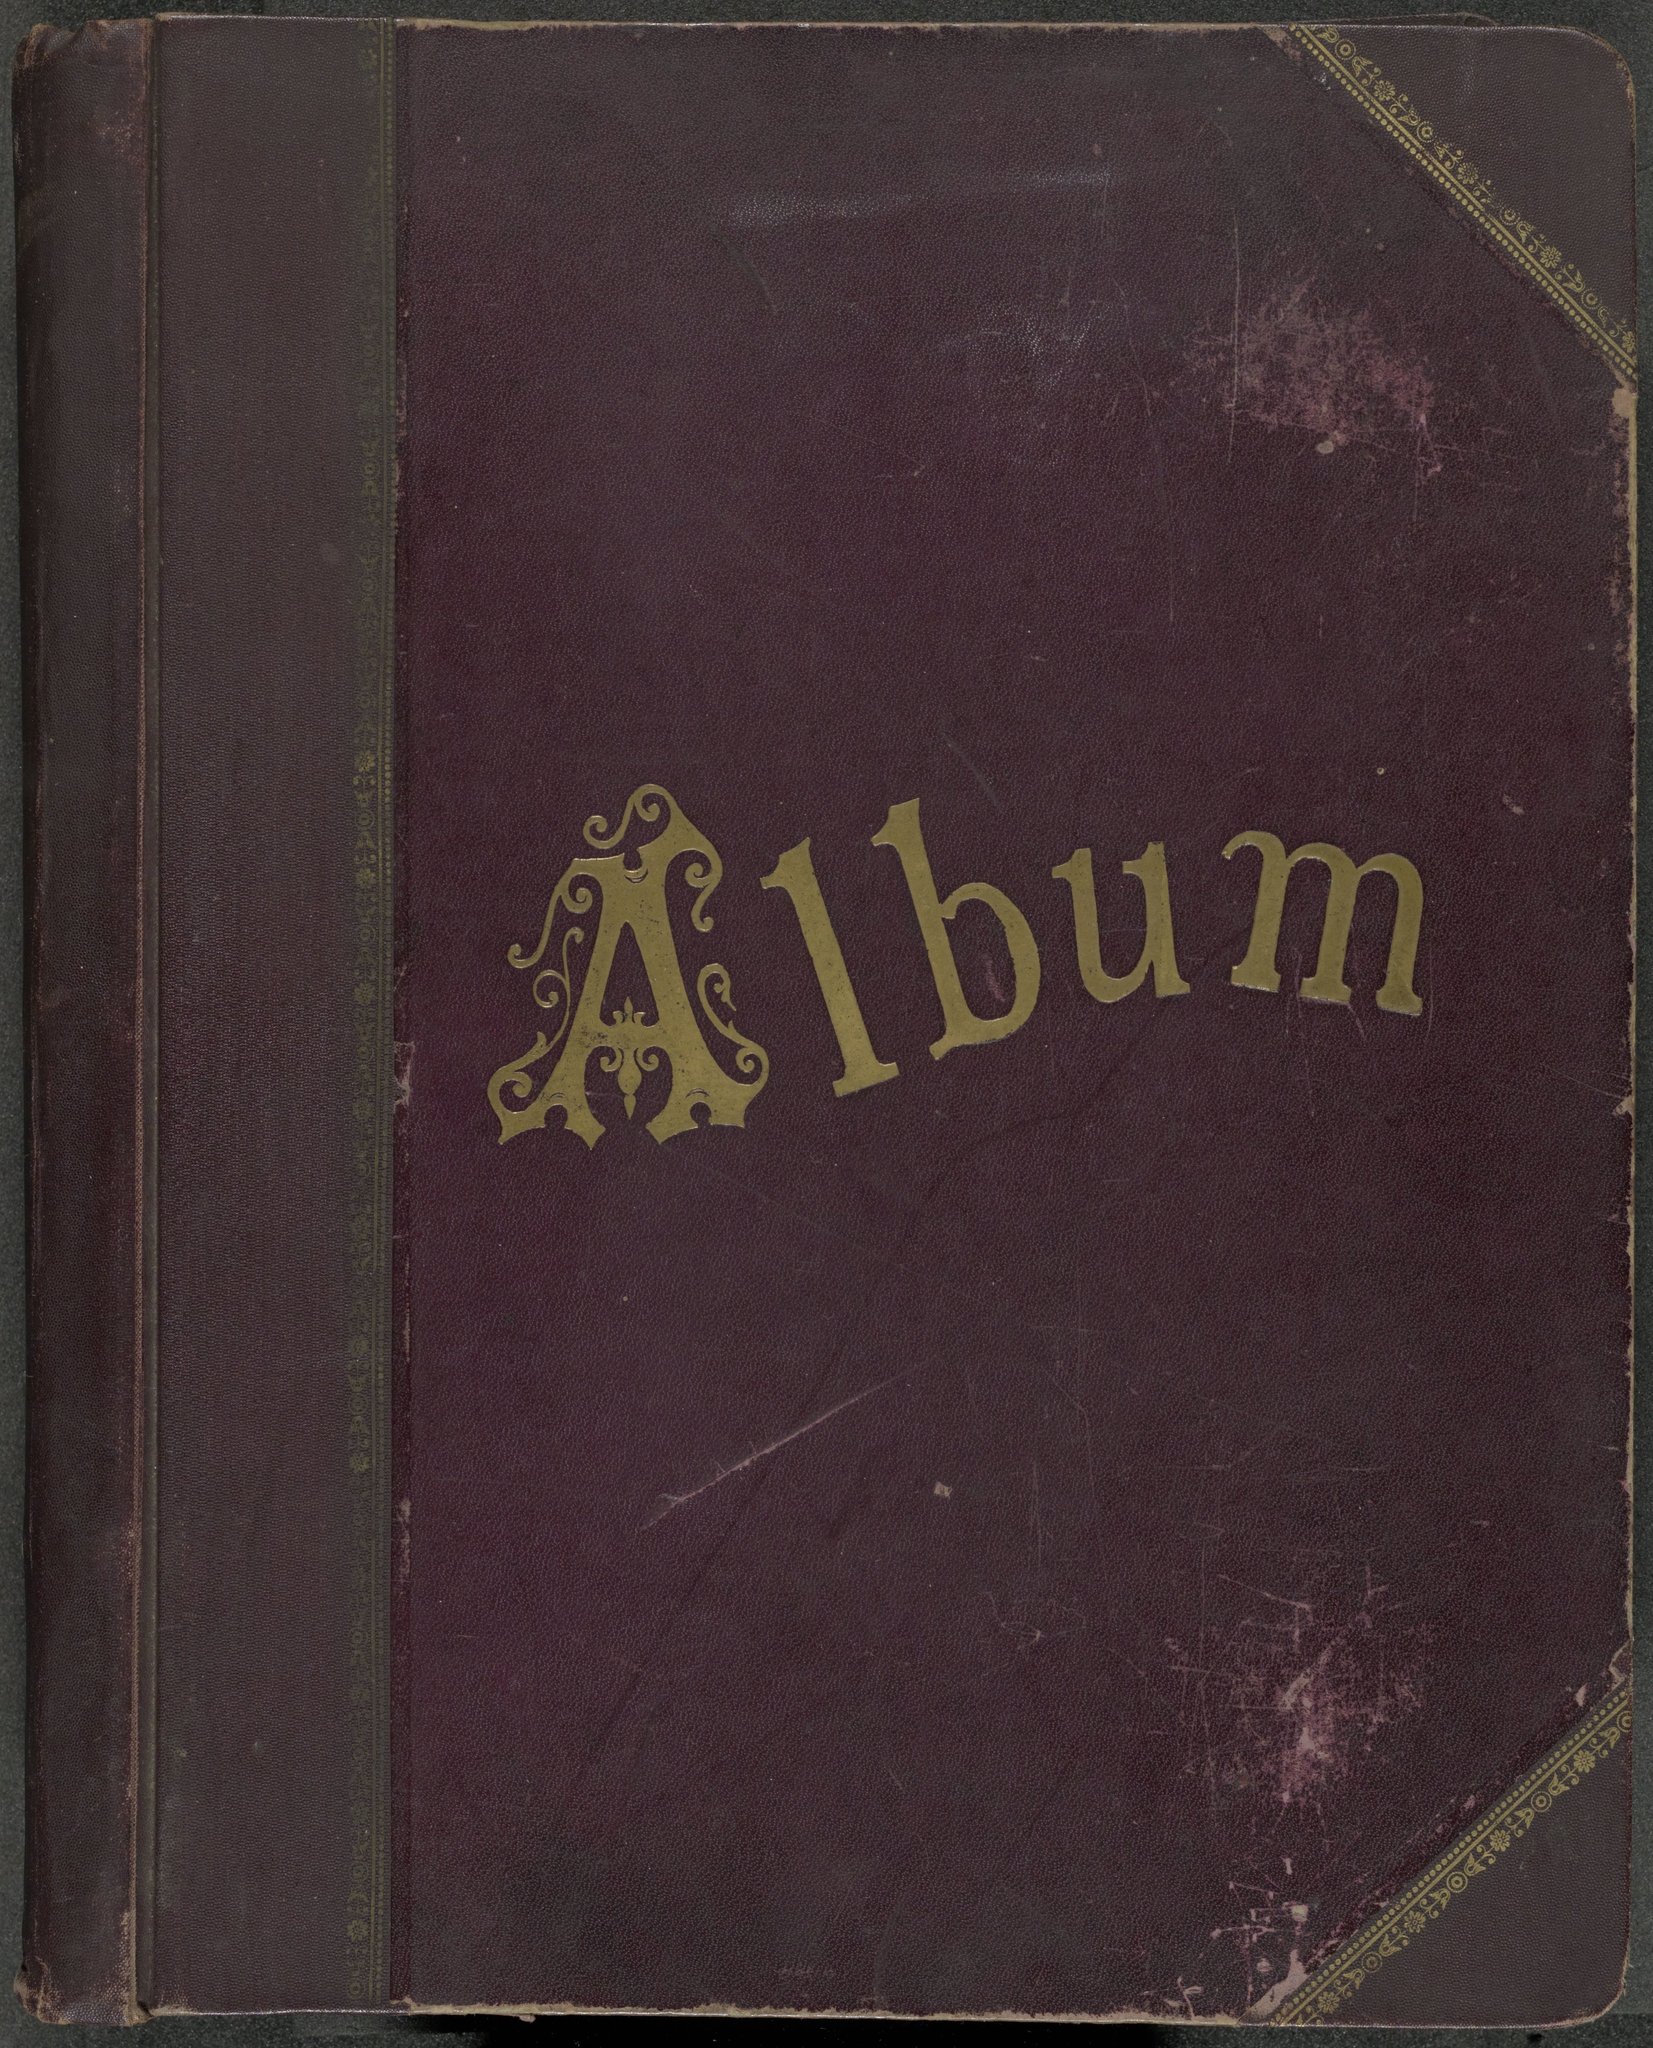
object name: slip in album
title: Album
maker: Anonymous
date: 1890-1900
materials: cardboard, linen, paper, photographic support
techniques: albumen print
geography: russia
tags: prospect of village, silhouette of village, travelling; tourism, prospect of city, town panorama, silhouette of city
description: Fotoalbum in roodbruine band met op het voorplat het woord 'Album' en versieringen in gouddruk en in reliëf. De schutbladen zijn van blauwgroen papier. Het album bevat 100 bladen met in totaal 78 foto's. De afdrukken zijn op het blad bevestigd met gekleurde strips papier waarachter de hoekpunten gestoken zijn. Oorspronkelijk bevatte het album meer foto's, getuige de bladen met stripjes zonder foto. De band bevat anonieme opnames van bezienswaardigheden in Sint-Petersburg en Moskou, zoals straten, poorten, kerken en pleinen. Een groot deel van de foto's is vervaardigd door Dimitri Ivanovitch Ermakov (1846-1916), die naast studioportretten, ook uitgebreide fotoreportages maakte van archeologische en topografische expedities. Van één van deze projecten, het fotograferen van de militaire weg door Georgië, zijn in het album afdrukken aanwezig. Niet uitgesloten is dat ook andere foto's in het album door hem vervaardigd zijn.